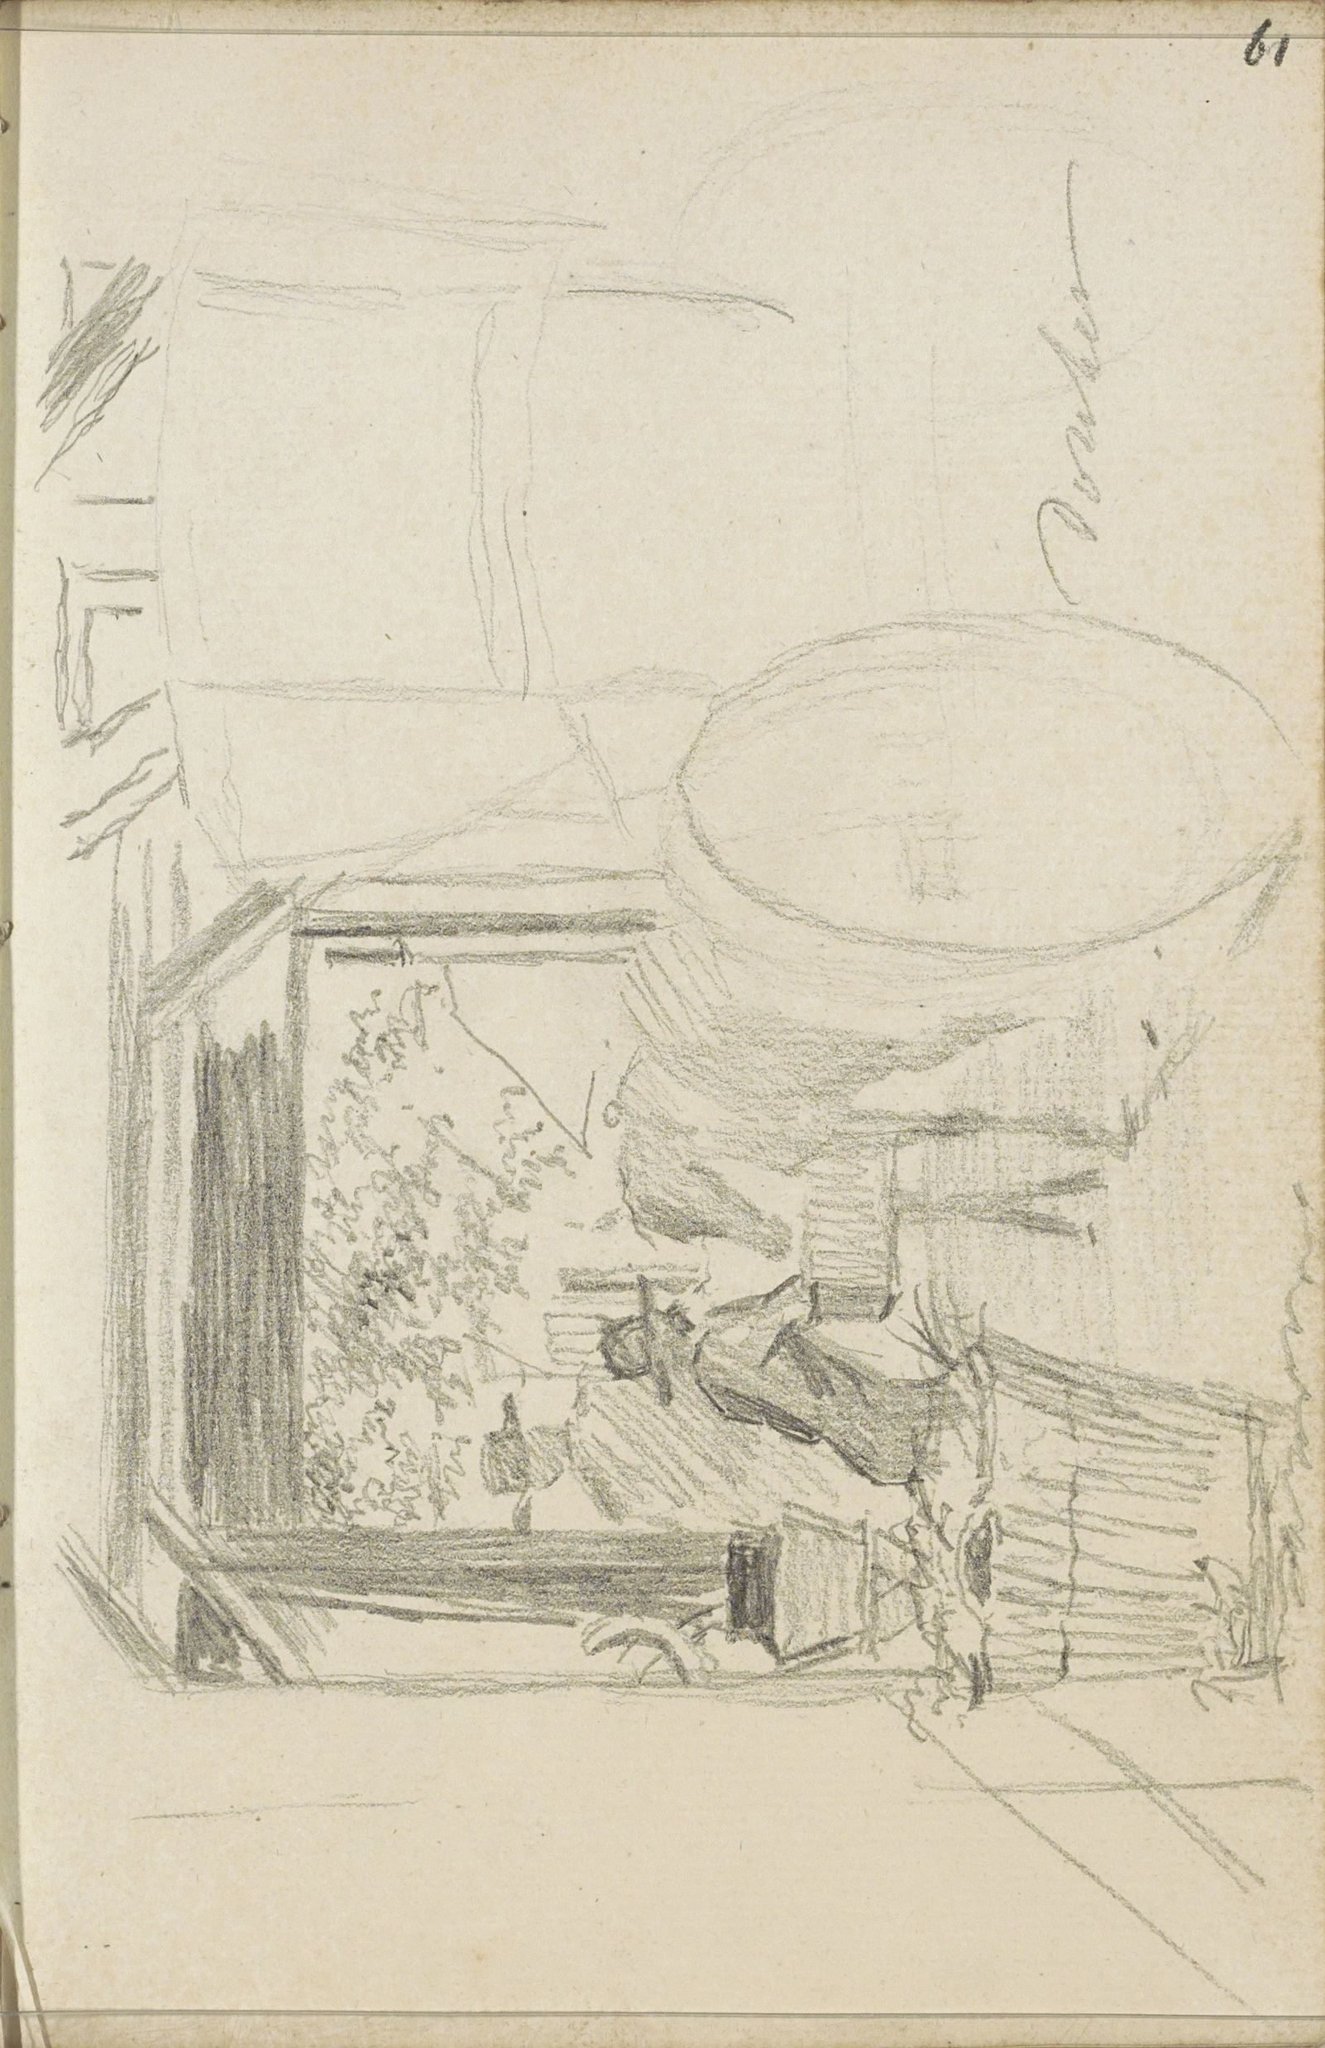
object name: sketchbook leaf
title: Man en een paard in een deuropening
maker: jacob perkois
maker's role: draughtsman, print maker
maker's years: 1756-1804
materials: paper, pencil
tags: open door, horse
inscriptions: kleurnotitie, handgeschreven in potlood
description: Tevens een studie, mogelijk van een kar. Bladzijde 61 uit een schetsboek met 78 bladzijden.